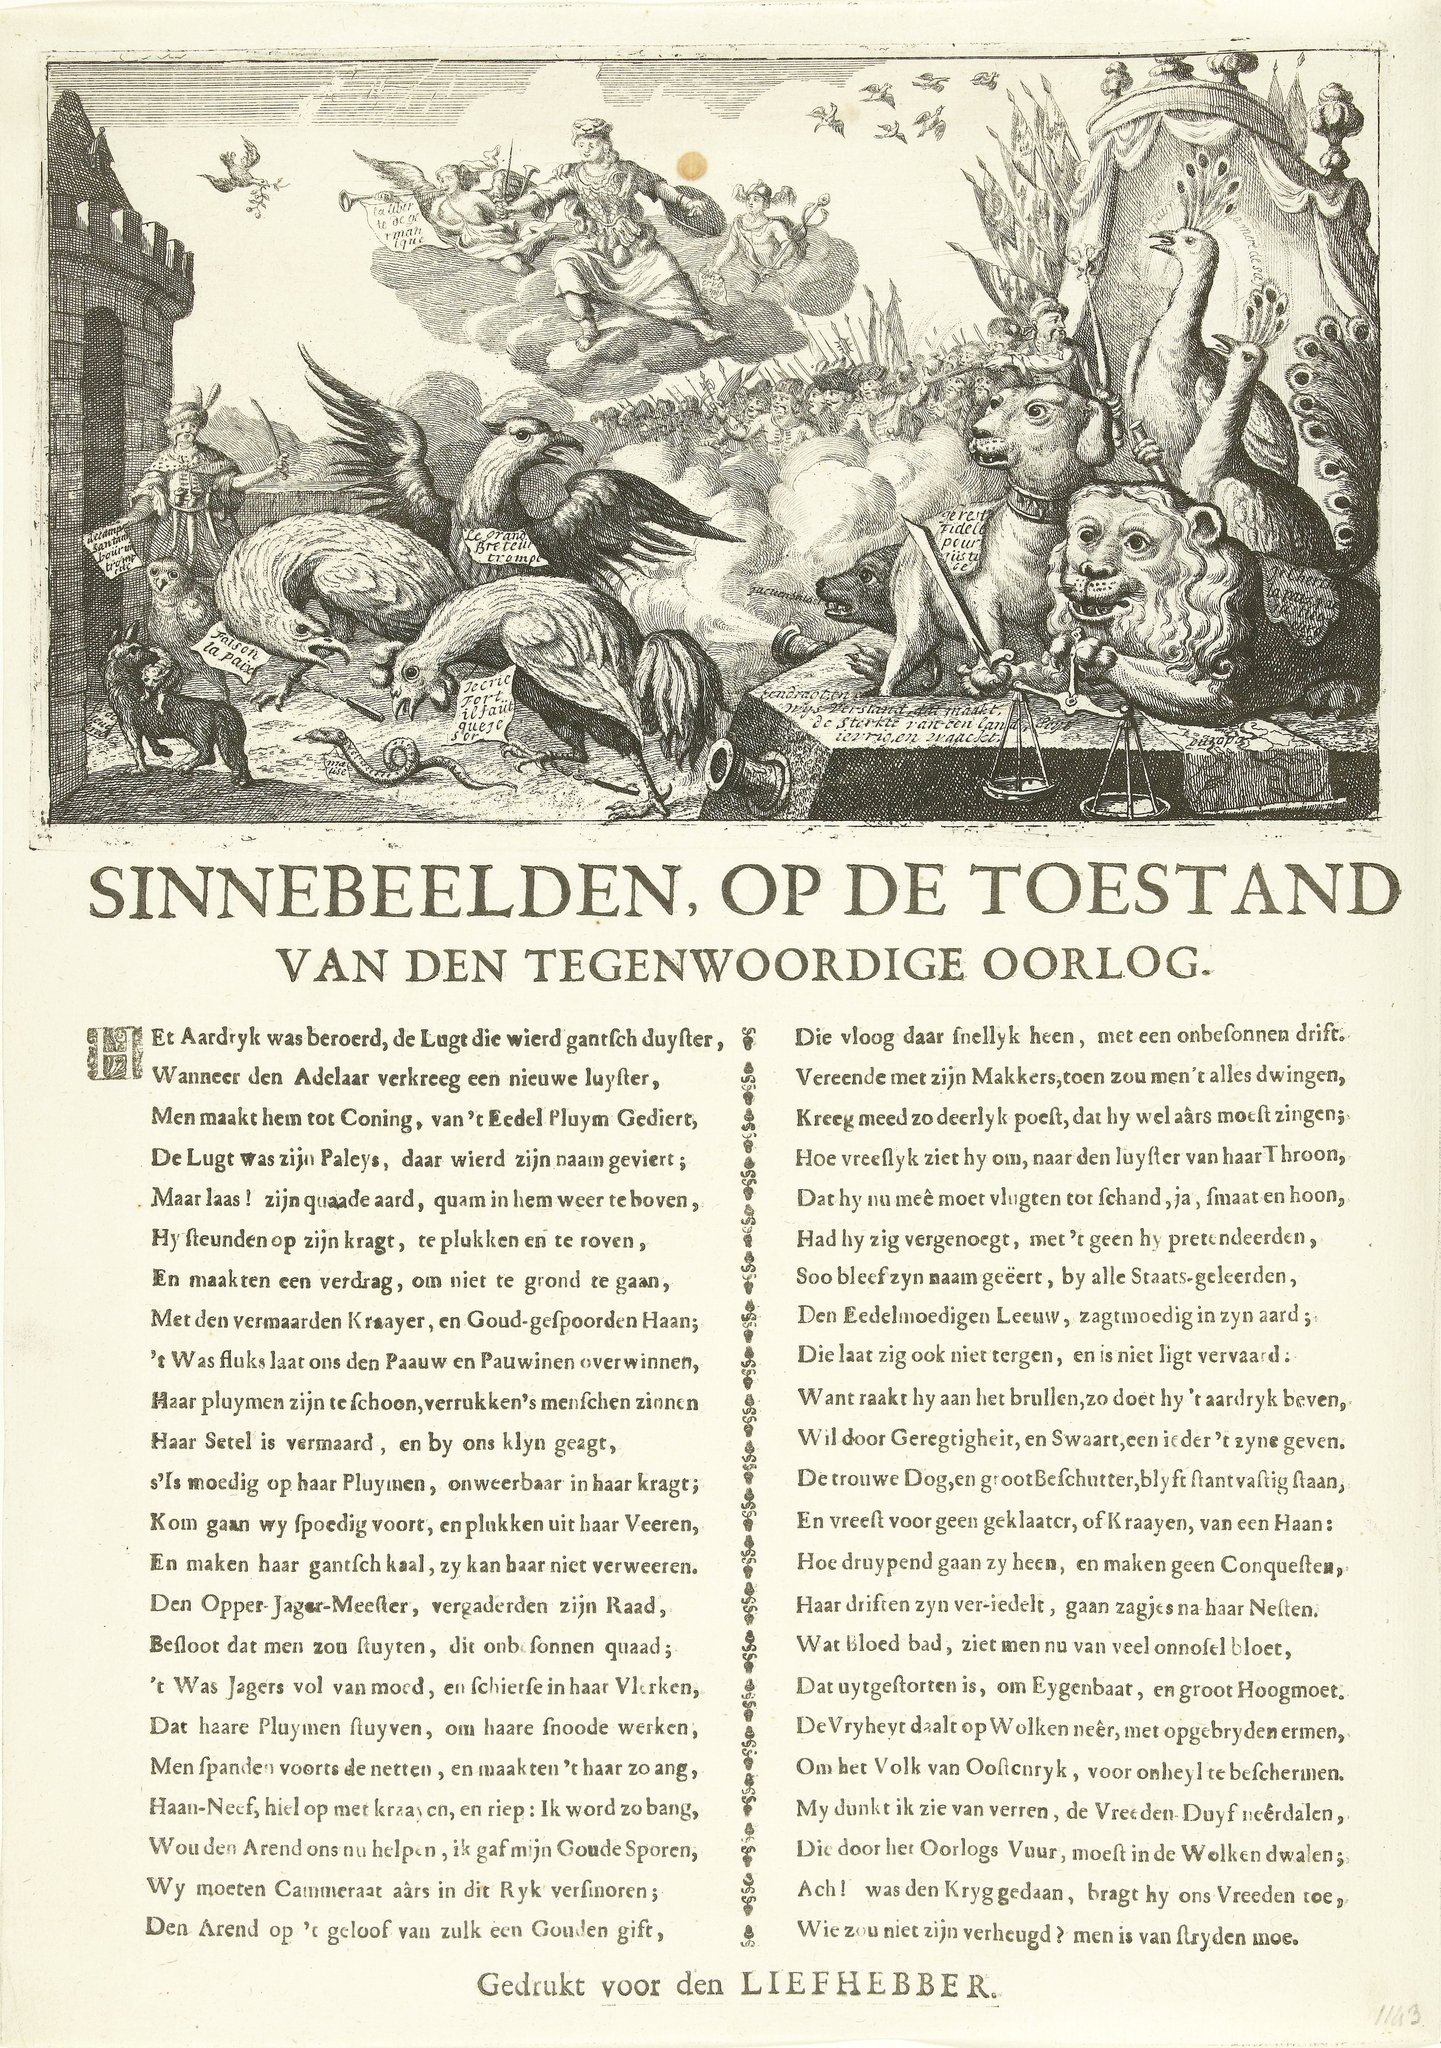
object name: print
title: Sinnebeelden, op de toestand van den tegenwoordige oorlog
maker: Anonymous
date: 1742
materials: paper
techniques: engraving, etching, letterpress printing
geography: northern netherlands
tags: vienna, maria theresia (rooms-duits keizerin), political caricatures and satires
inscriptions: collector's mark: Lugt 2228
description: Allegorie op de Oostenrijkse successieoorlog waarin de strijdende partijen als dieren worden voorgesteld. Op de voorgrond links strijden de Oostenrijkse adelaar en de Franse haan om een slangetje, rechts kijken de Nederlandse Leeuw, de Engelse Dog en enkele pauwen toe. In de wolken Bellona. Op het blad onder de plaat een vers in twee kolommen.